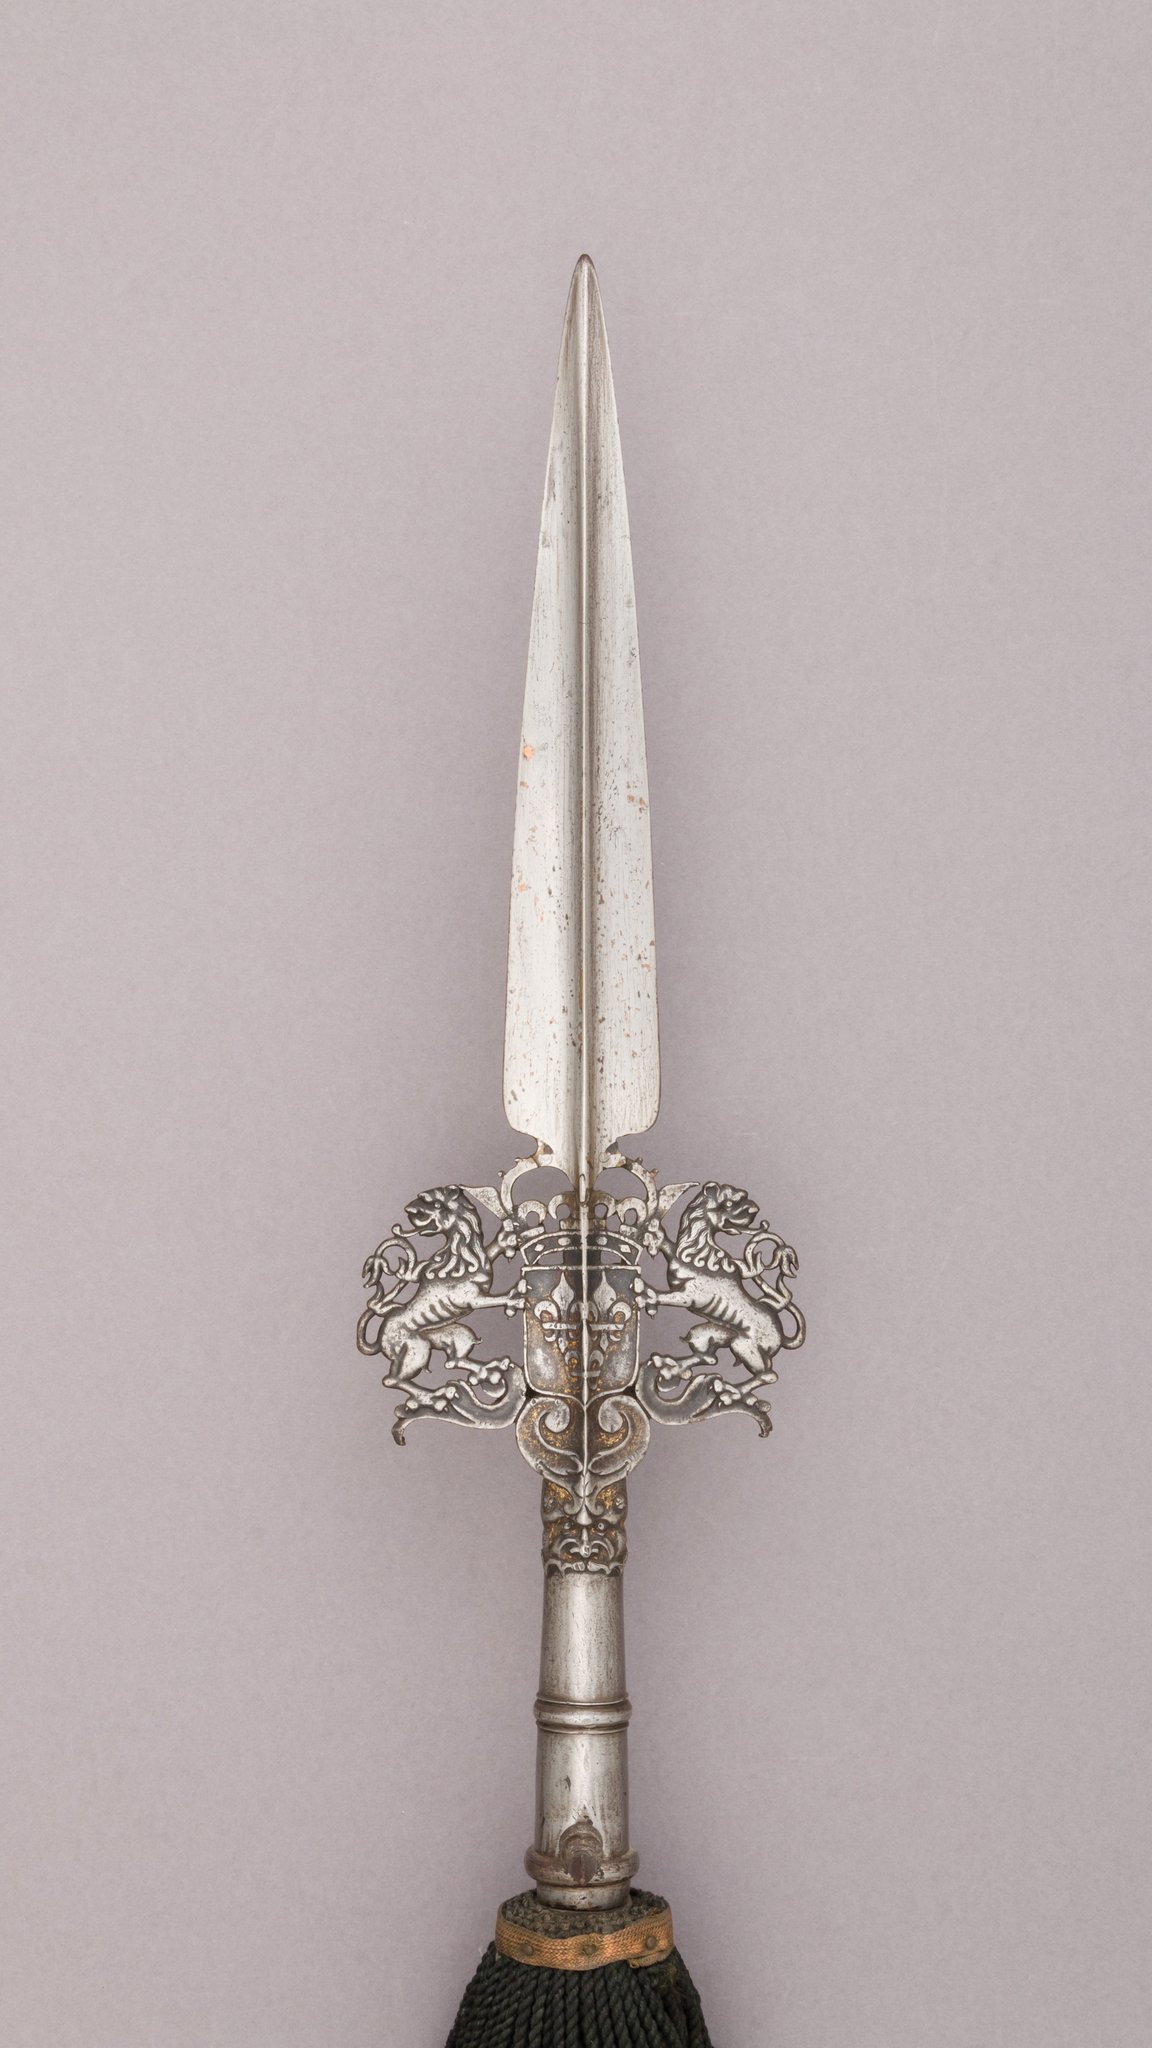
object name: partisan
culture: french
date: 1701-1800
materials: gold, metal thread, steel, textile, wood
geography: france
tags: coat of arms